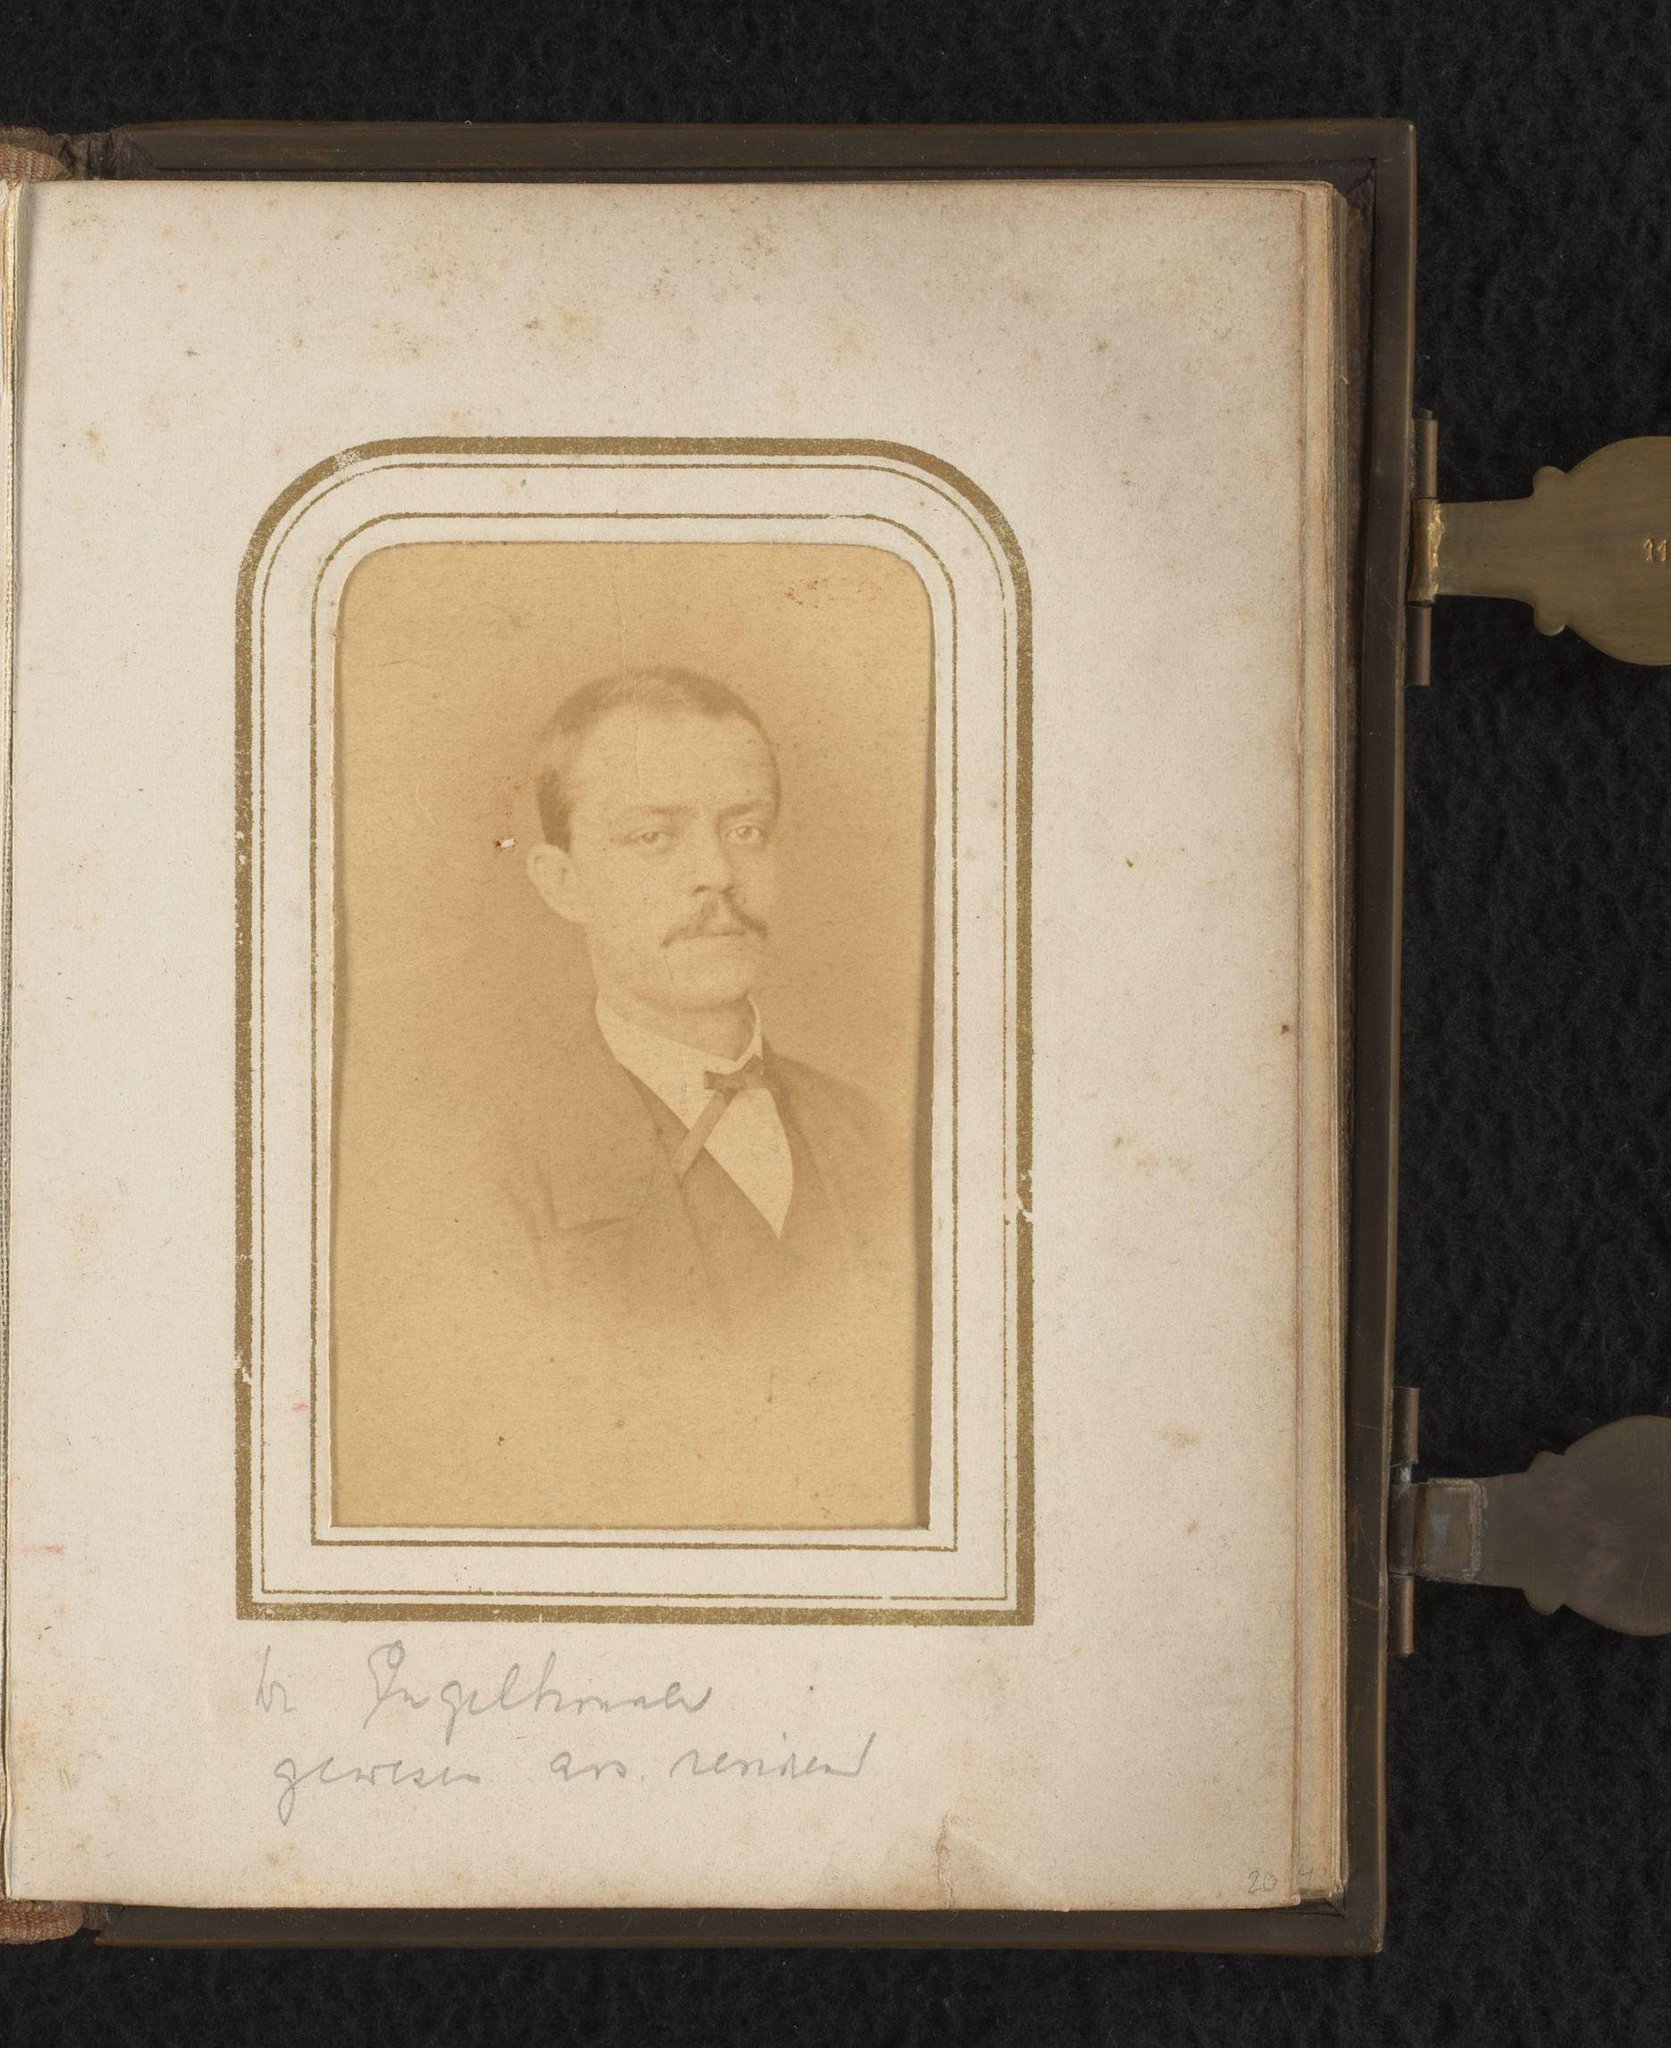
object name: photograph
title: Portret van een man met snor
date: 1860-1900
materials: cardboard, photographic support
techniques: albumen print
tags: moustache, adult man, historical persons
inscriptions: annotation: ‘D. Engel[...]/ ge[...]’, annotation: ‘D. Engel[...]’, inscription: ‘W. J. Olland/ & zoon/ Java (...)’